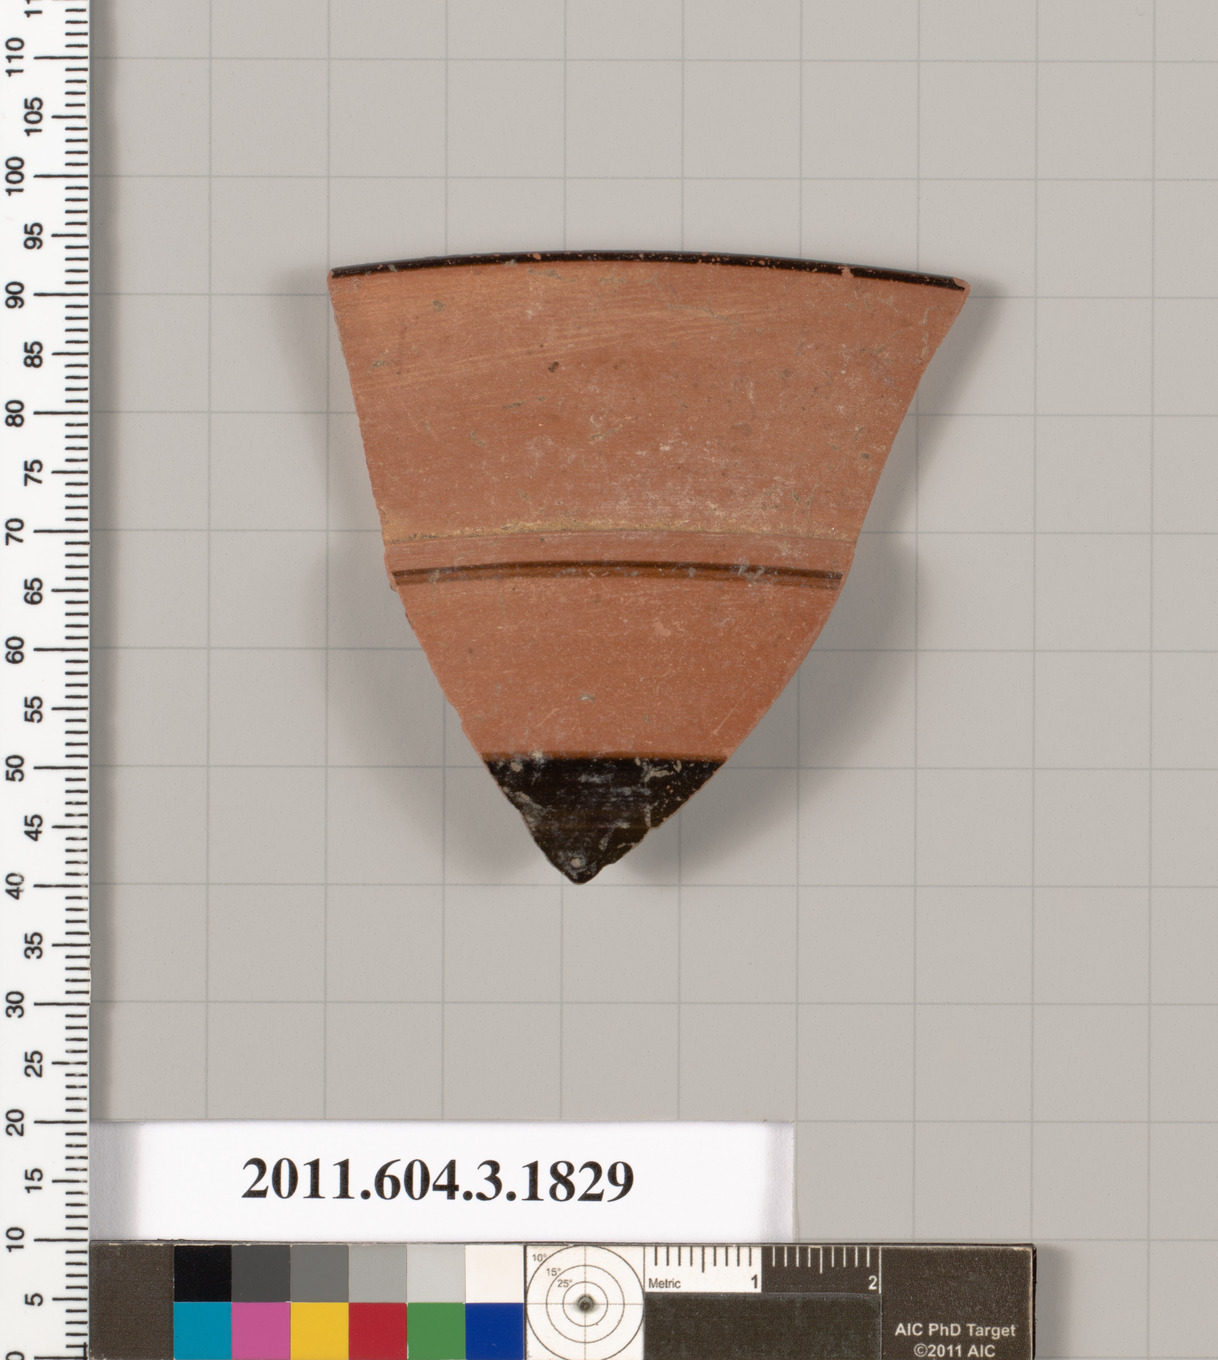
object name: kylix fragment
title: Terracotta fragment of a kylix: Lip cup (drinking cup)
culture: greek, attic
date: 560-525 BCE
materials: terracotta